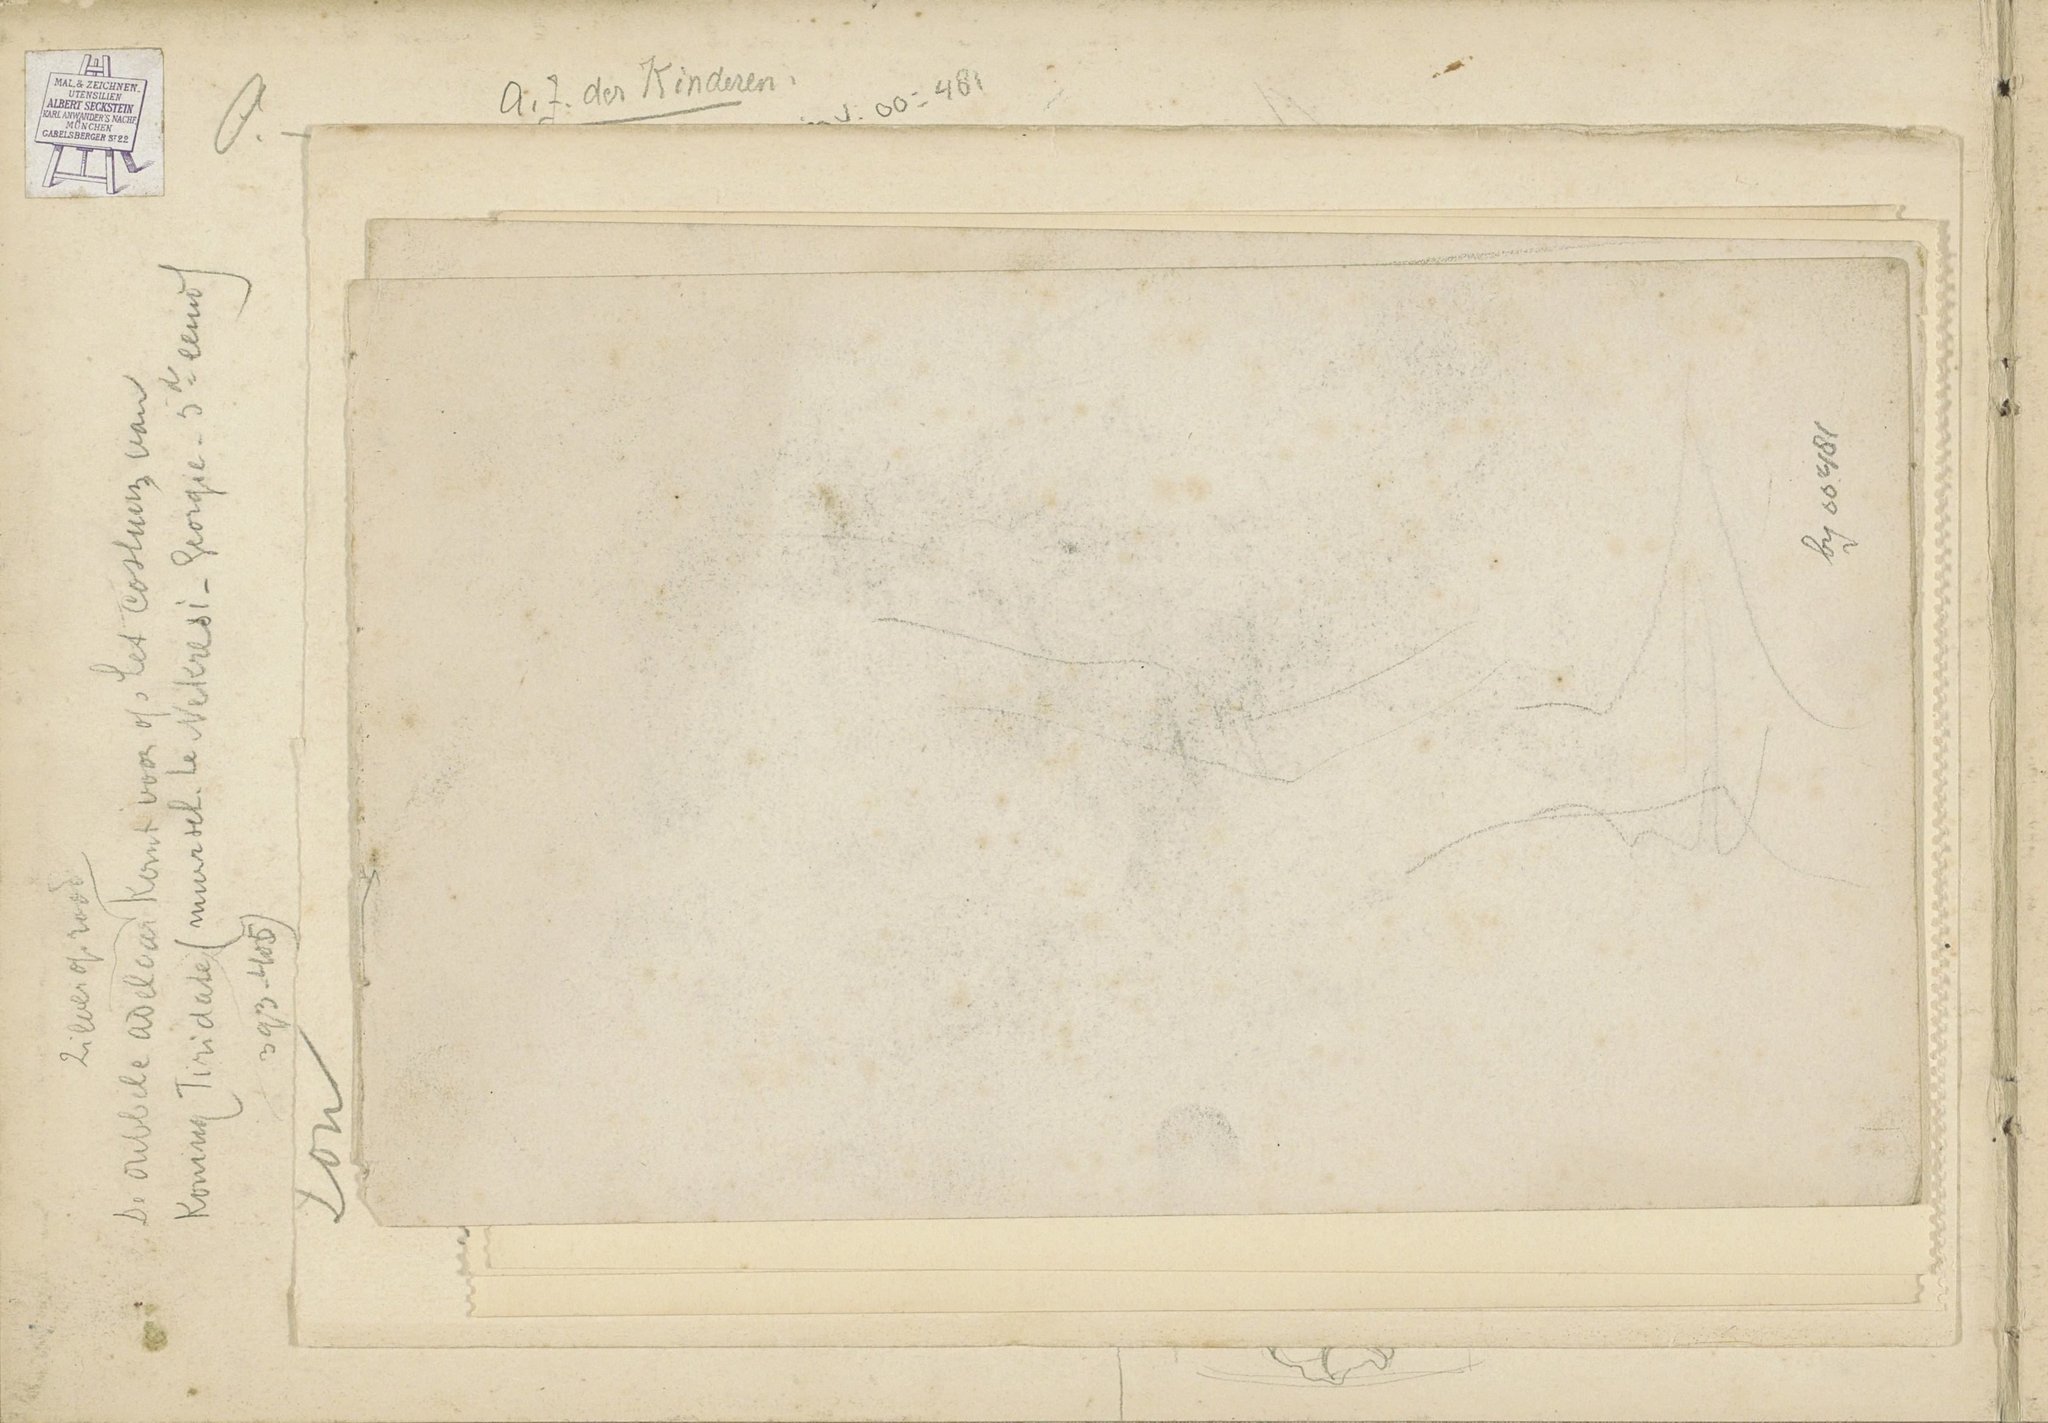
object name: sketchbook leaf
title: Studie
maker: antoon derkinderen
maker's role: draughtsman, painter, print maker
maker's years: 1859-1925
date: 1869-1925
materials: paper, pencil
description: Verso van een losse tekening tussen het voorste schutblad en blad 1 uit een schetsboek met 28 bladen.